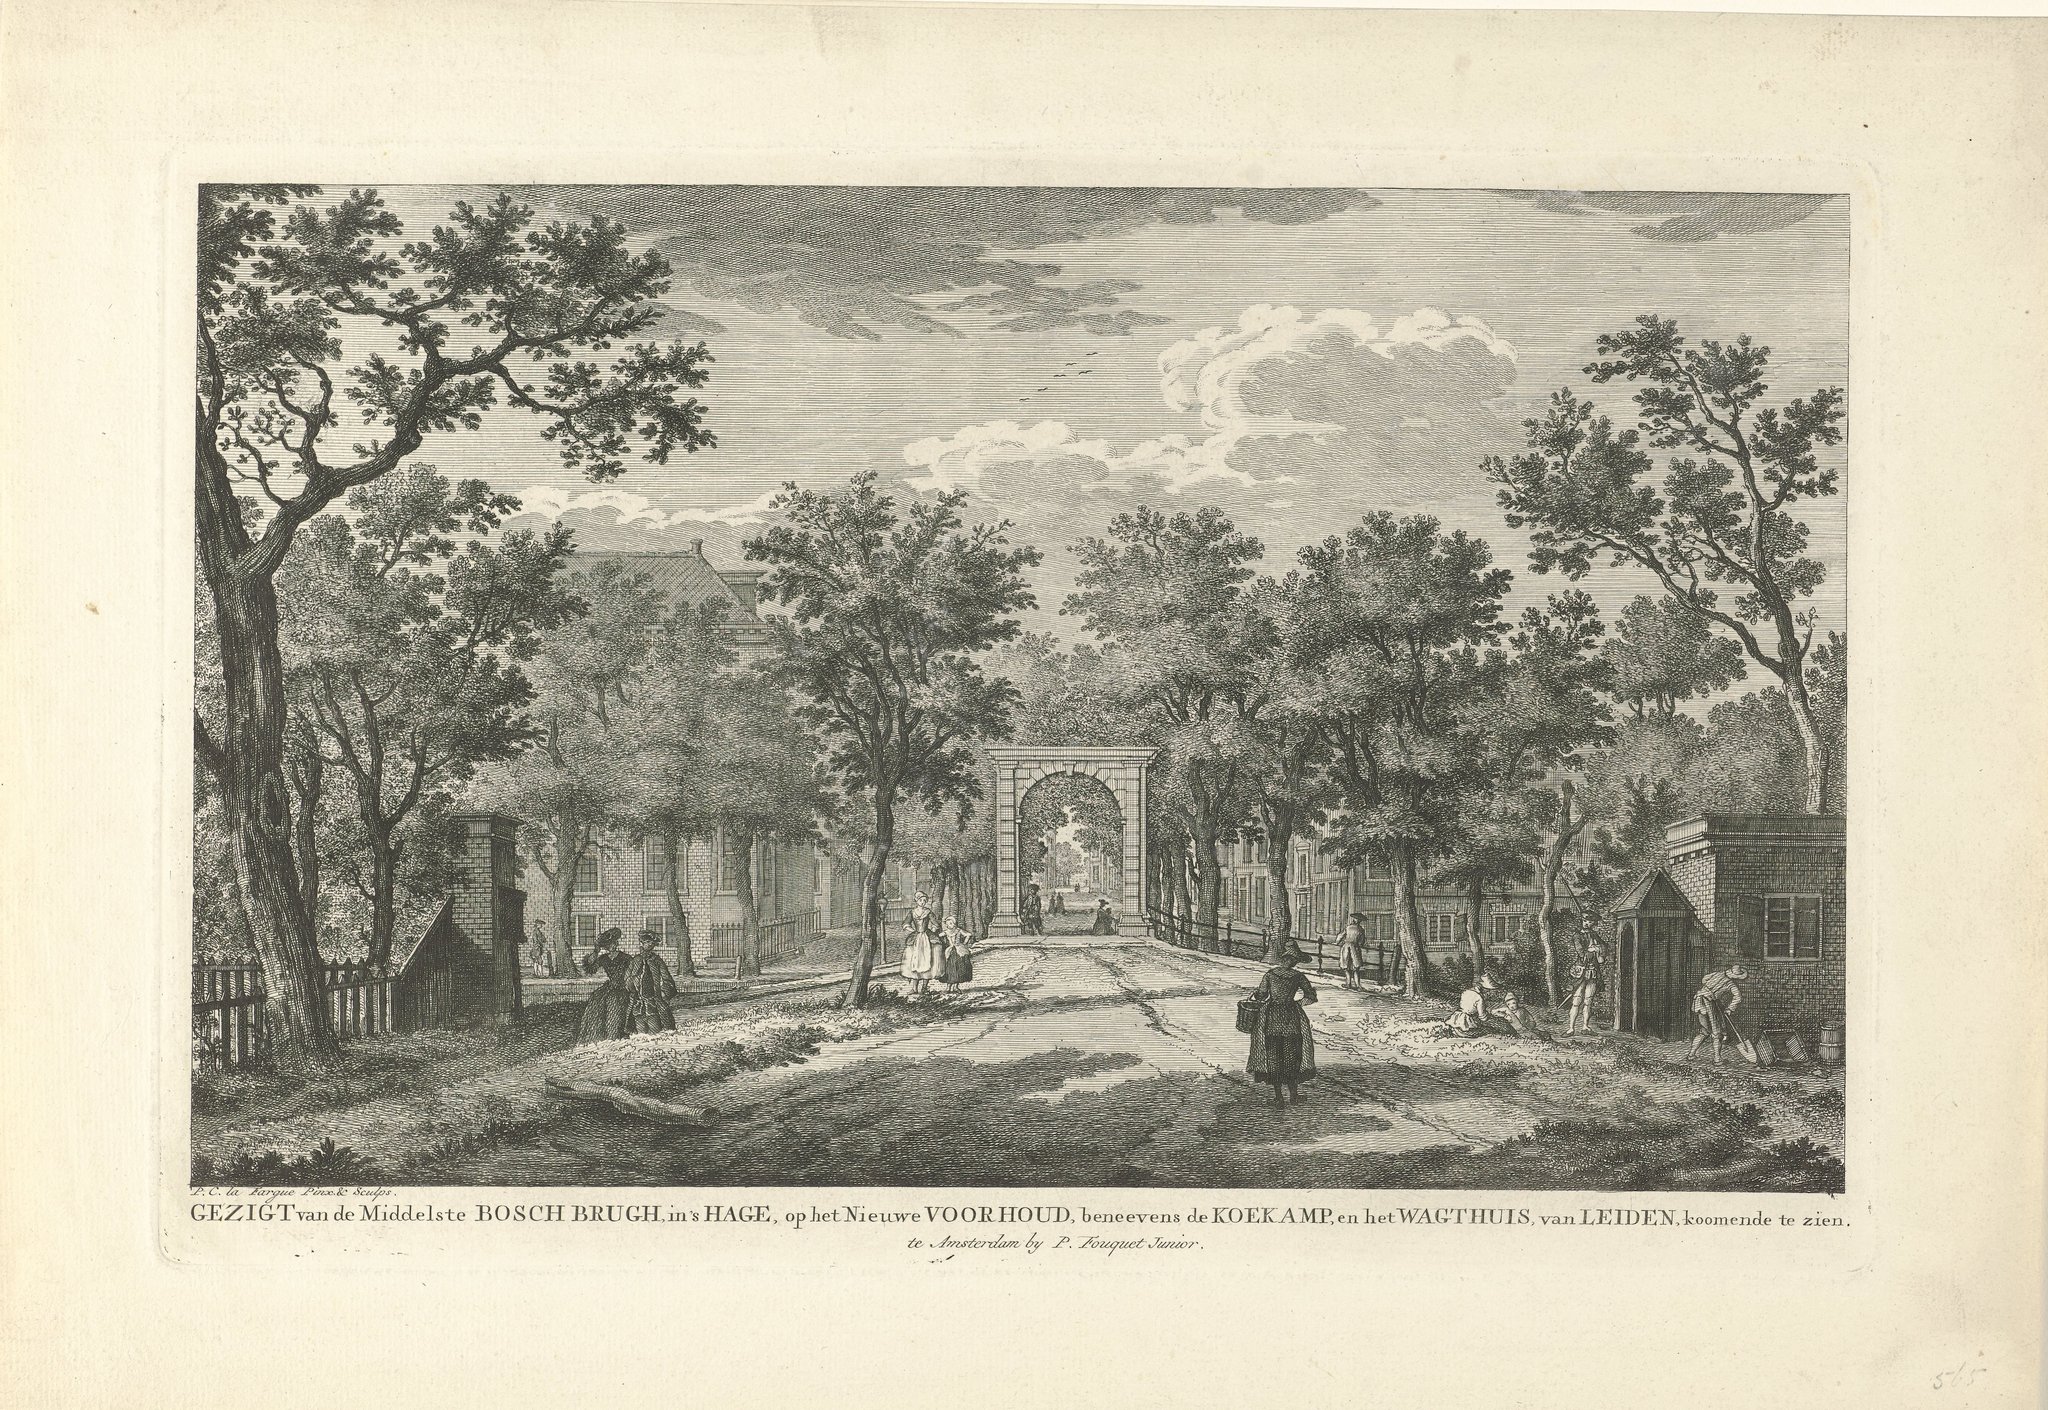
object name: print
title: Acht gezichten in Den Haag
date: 1764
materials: paper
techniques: engraving, etching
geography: amsterdam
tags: bridge in city across river, canal, etc., guard duty, keeping sentry, lane, alley (+ city(-scape) with figures, staffage)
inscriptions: collector's mark: Lugt 2228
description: Gezicht op de Bosbrug over de Prinsessegracht te Den Haag met daarachter het Korte Voorhout (voorheen Nieuwe Voorhout). Voor de brug de Koekamp met geheel rechts een schildwacht bij een wachtershuis. Prent uit een serie van acht gezichten in Den Haag.